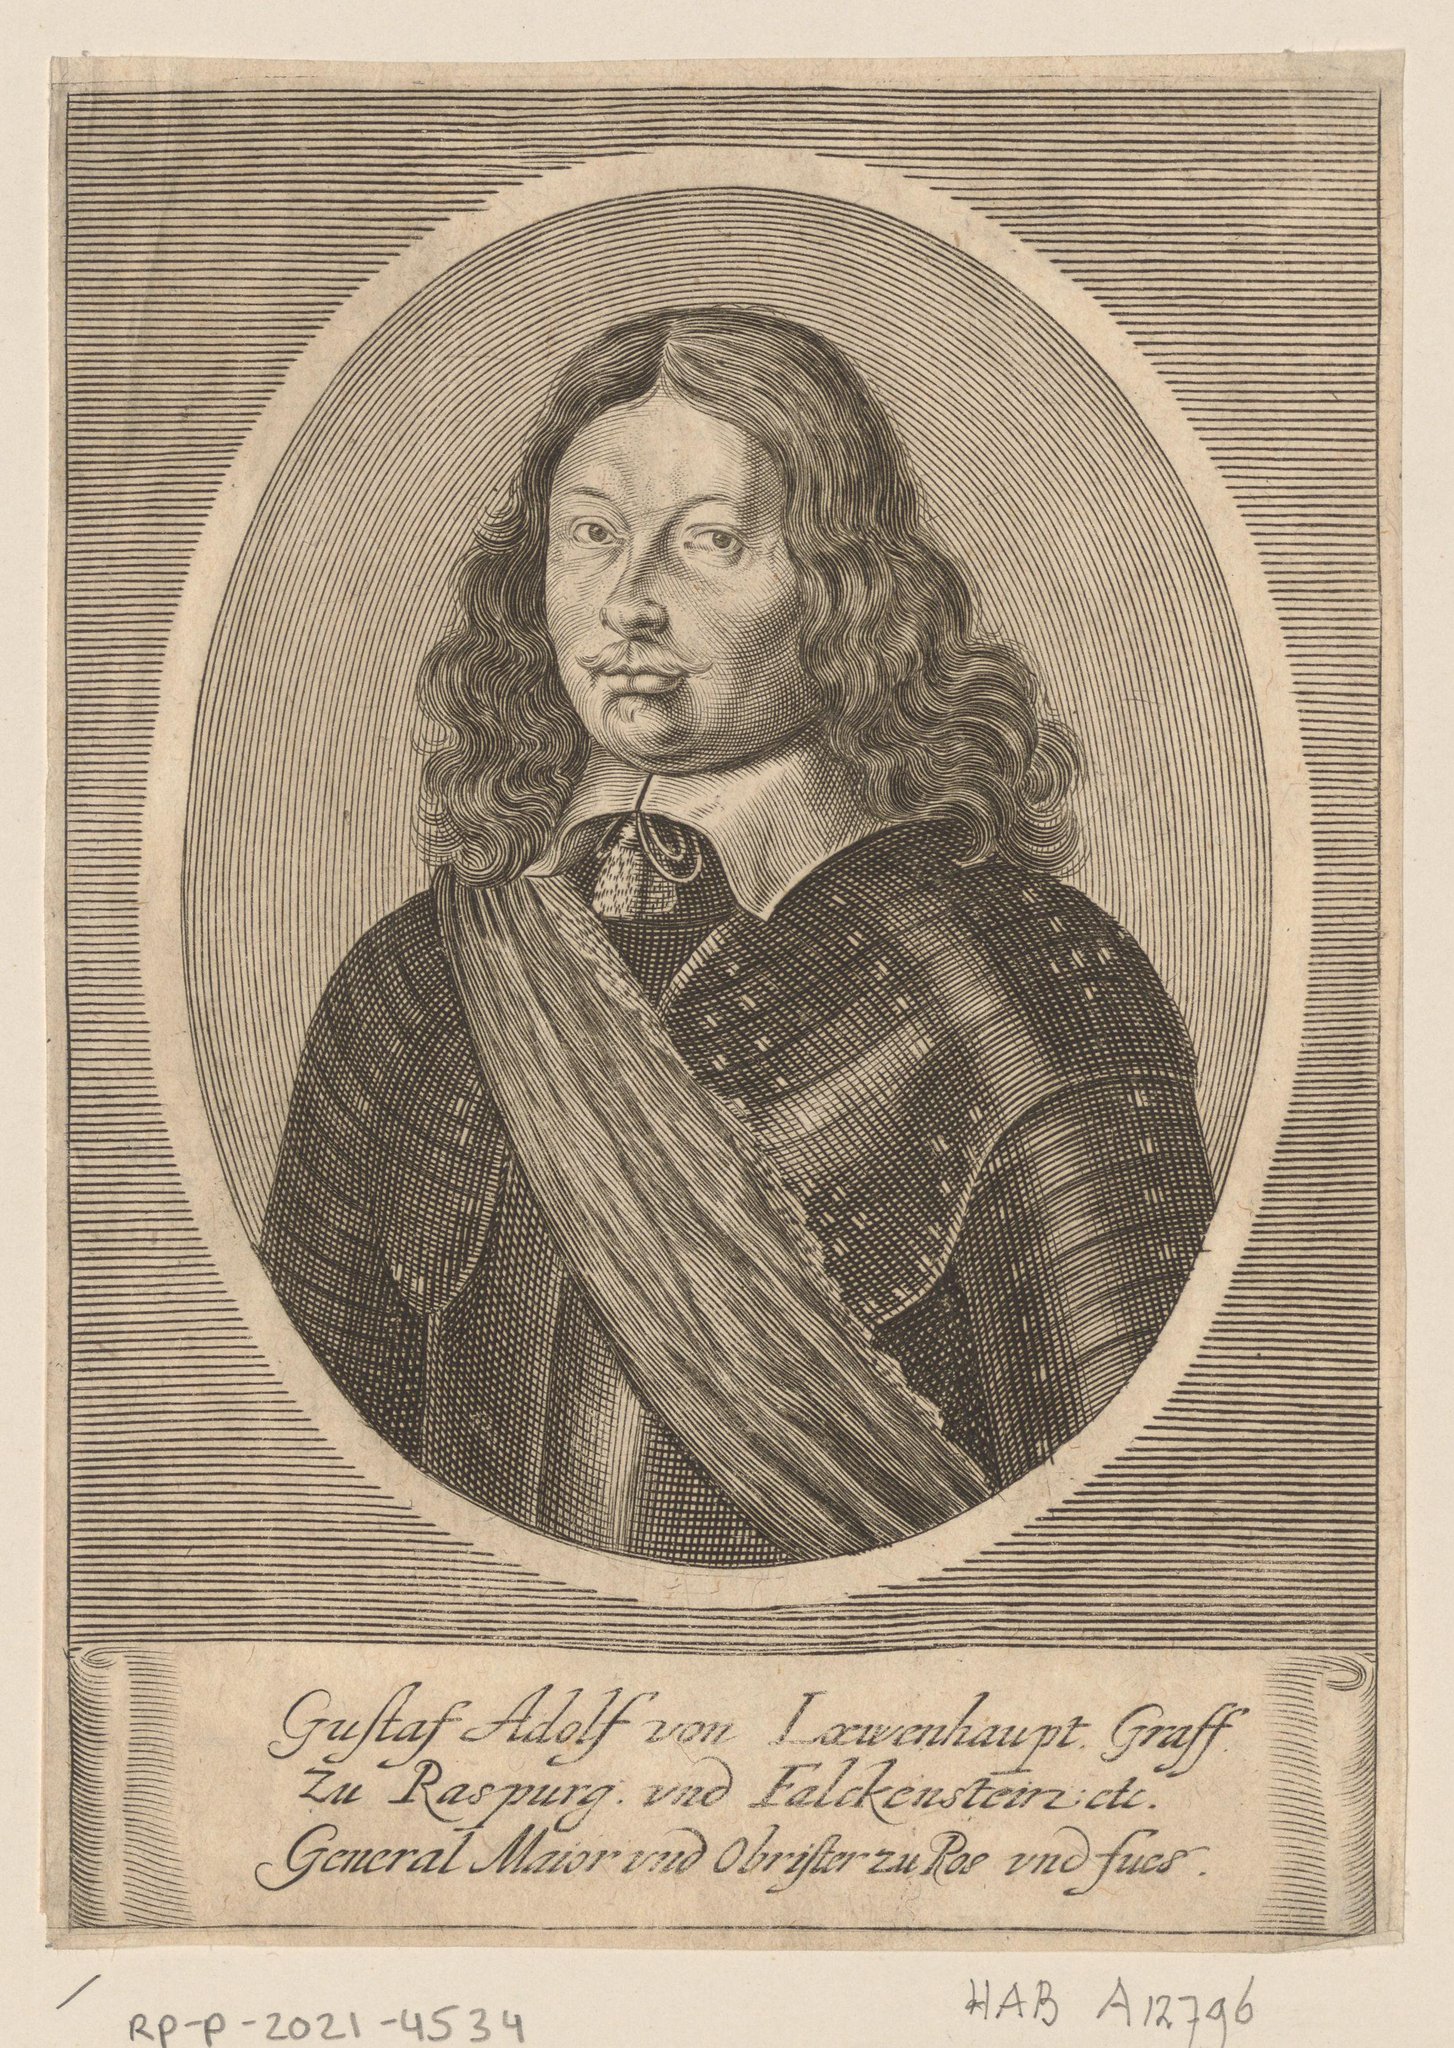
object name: print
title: Portret van Gustaf Adolf Lewenhaupt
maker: Anonymous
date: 1645-1720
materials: paper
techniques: engraving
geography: germany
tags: ornament ~ medallion, armour, historical persons